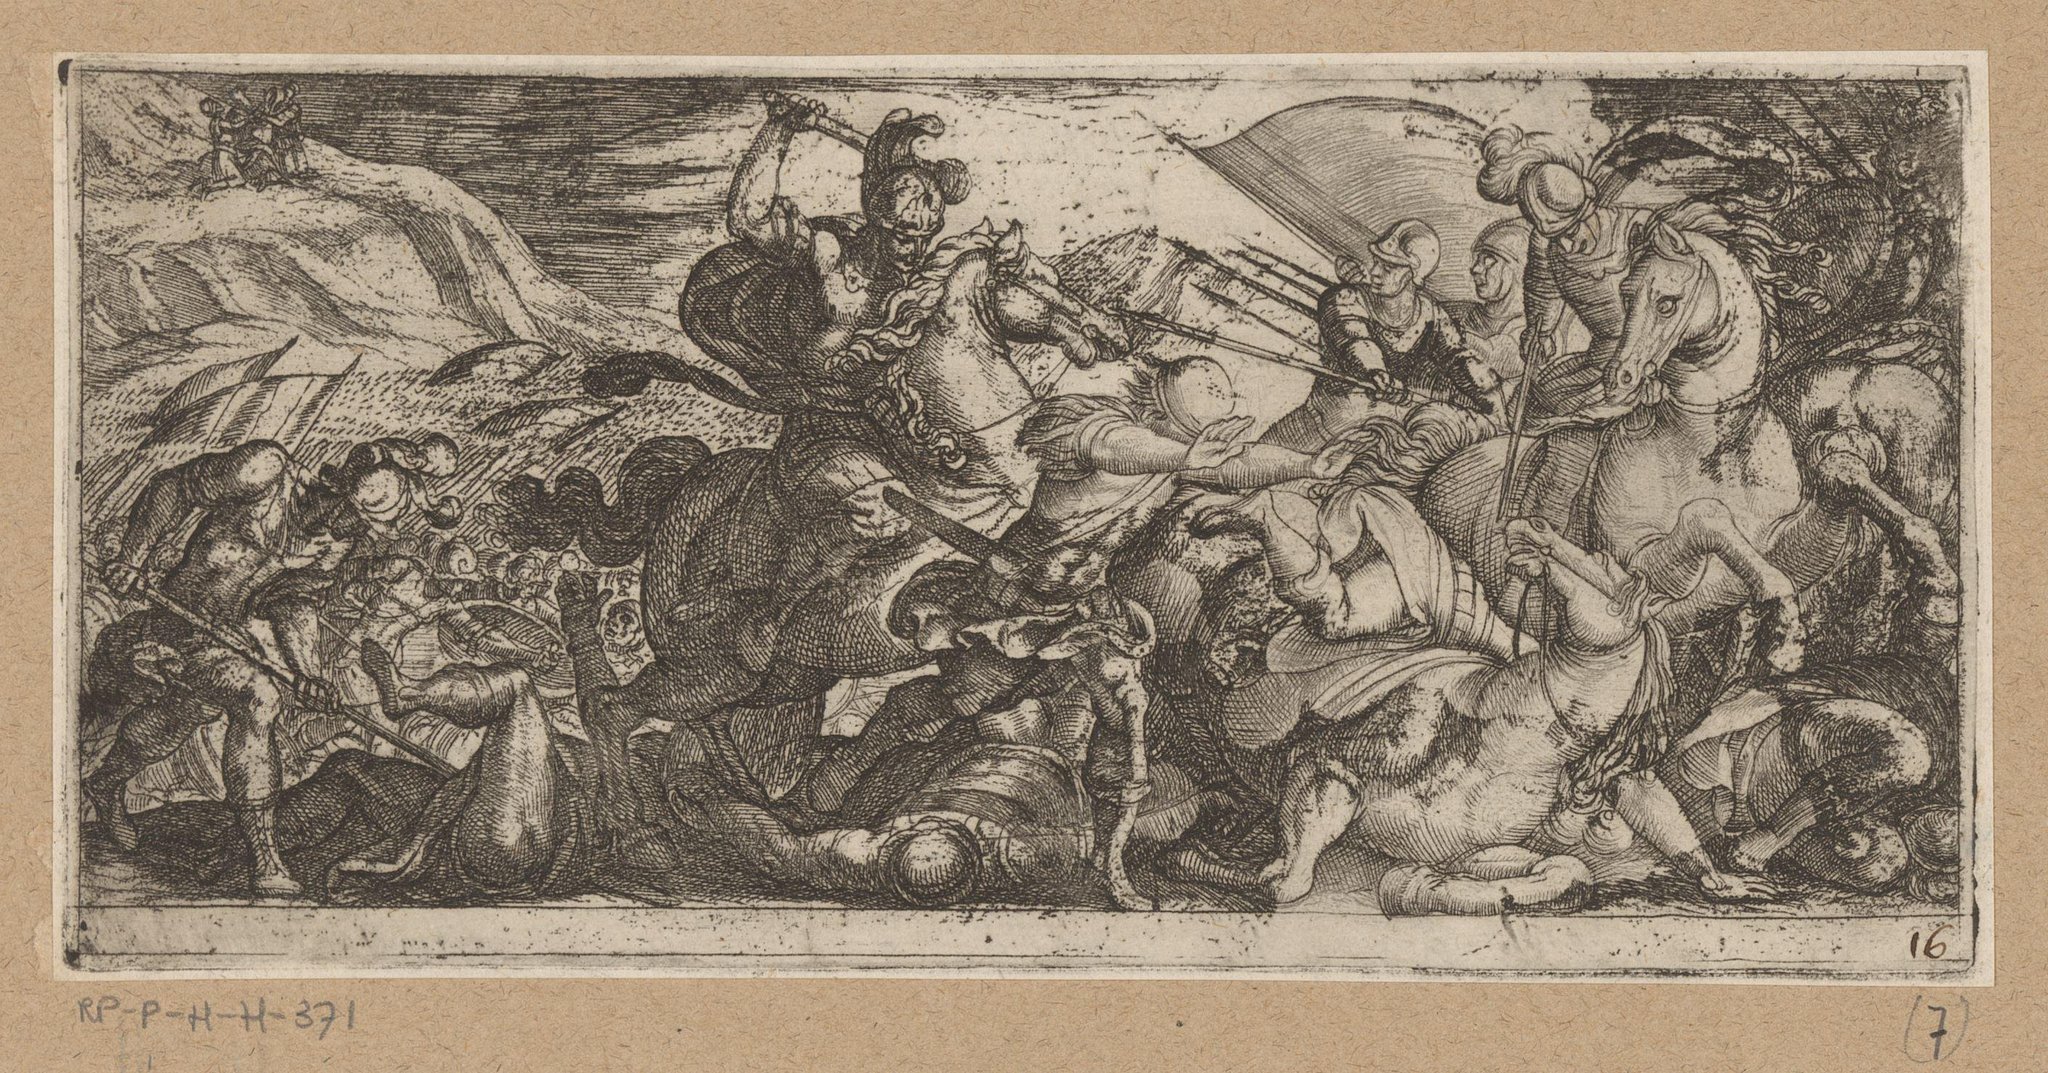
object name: print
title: Cavalerie aanval met vluchtende soldaten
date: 1565-1630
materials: paper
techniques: etching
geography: italy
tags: battle, warfare; military affairs (+ cavalry, horsemen), the soldier; the soldier's life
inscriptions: number: ‘16’, collector's mark: Lugt 11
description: Deze prent maakt deel uit van een reeks van 10 prenten (+ titelprent) met gevechtsscènes. Antonio Tempesta maakte ook een tweede serie met gevechtsscènes van 9 prenten (+titelprent).